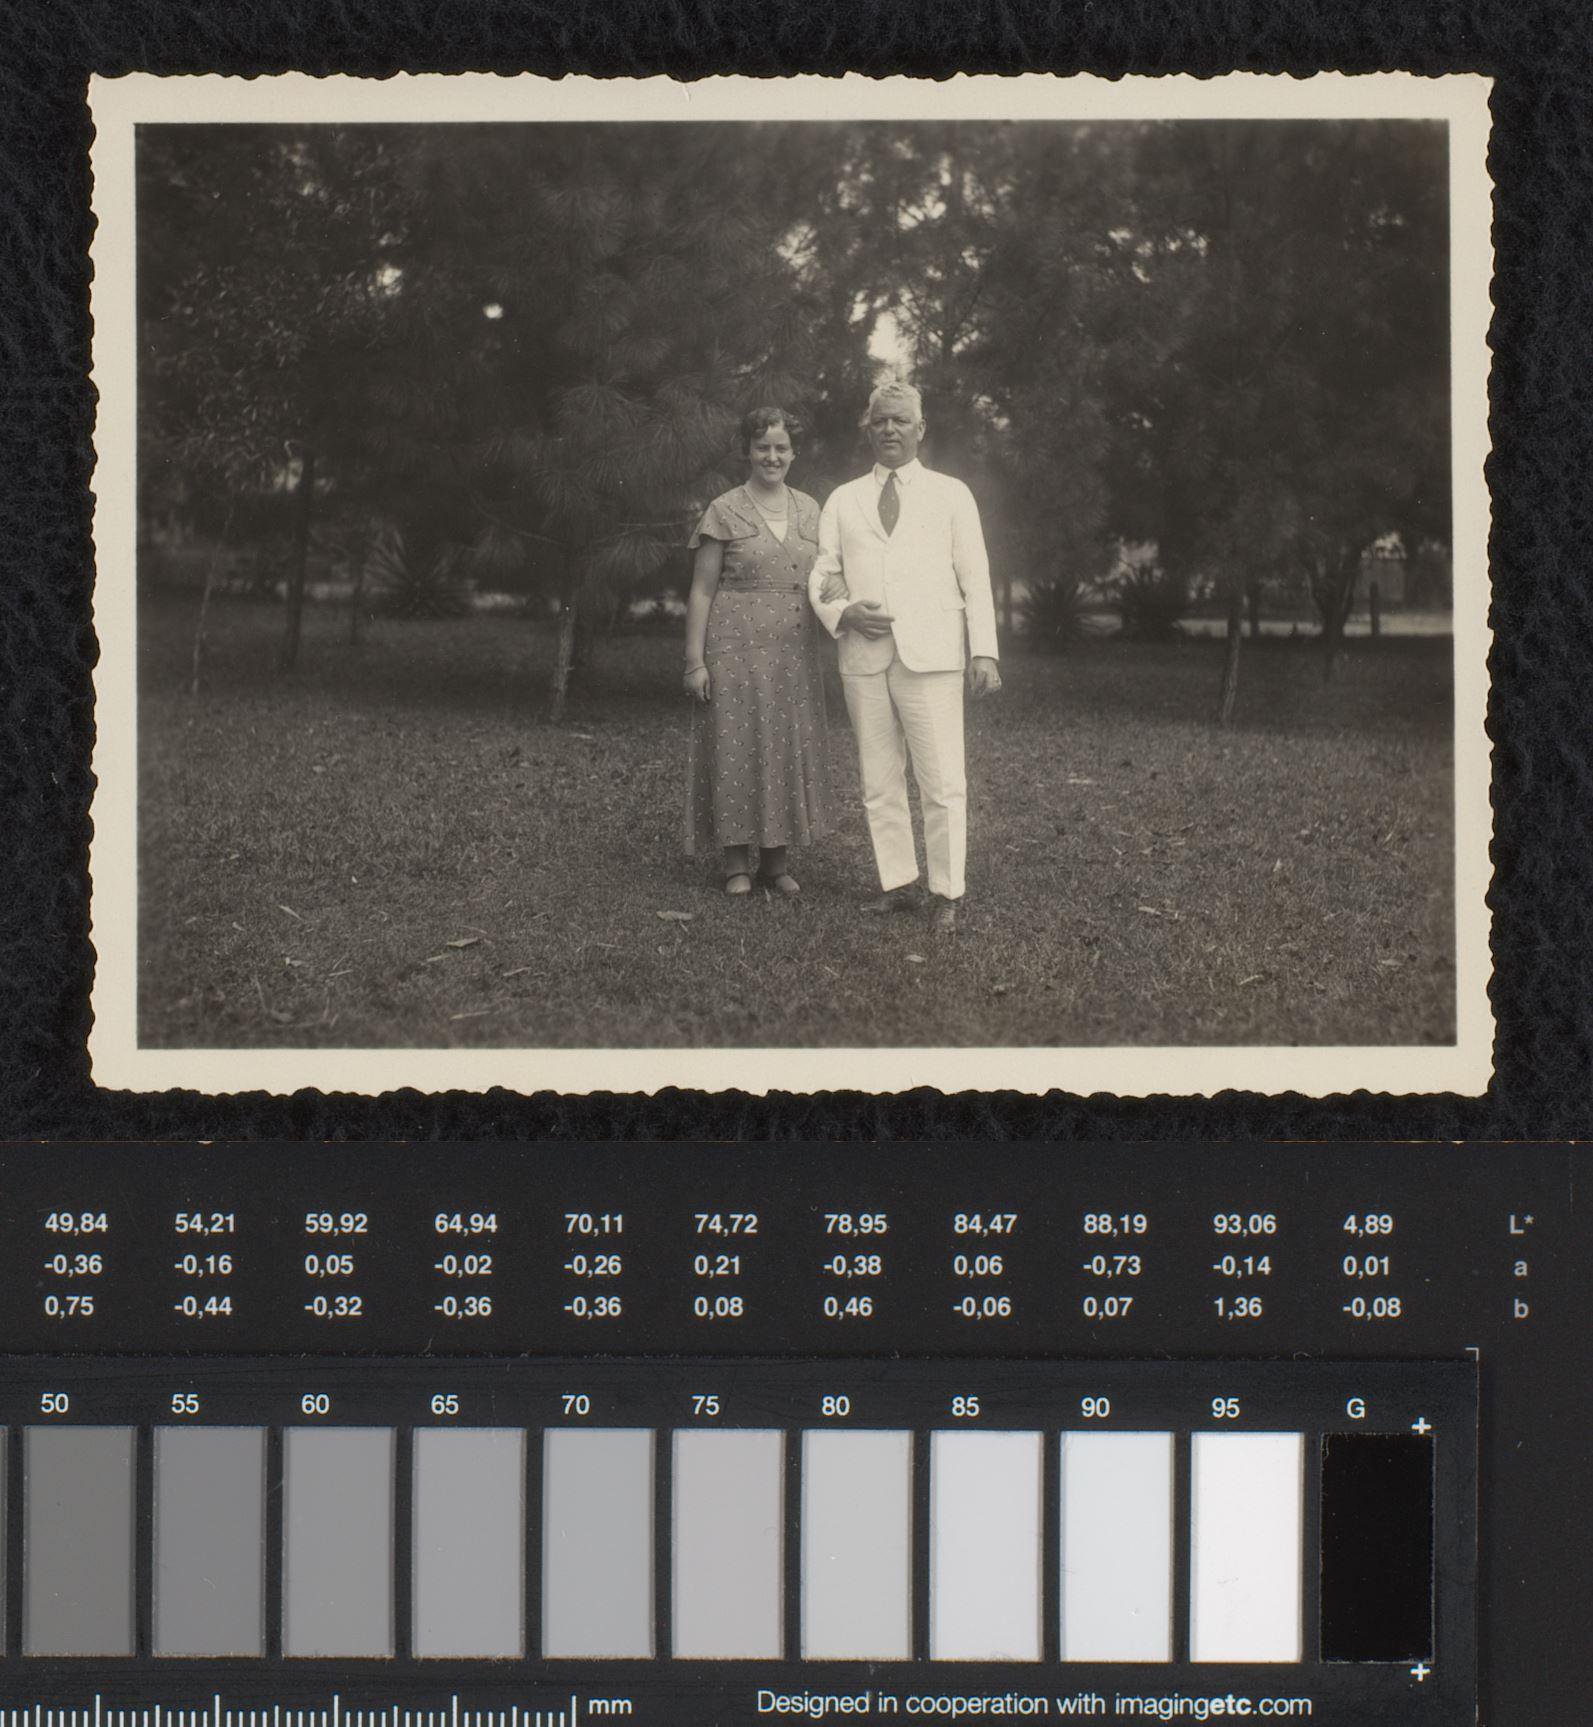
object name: photograph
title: Machteld Honig met echtgenoot, 1933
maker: Anonymous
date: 1908-1933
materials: photographic support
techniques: gelatin silver print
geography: sumatra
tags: rotterdam, official, koog aan de zaan, arnhem, machteld anna cornelia honig, historical persons - bb - woman, historical persons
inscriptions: inscription: ‘Taroetoeng Aug: '33’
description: Machteld Honig poserend met haar man in de tuin van hun woning in Taroetoeng, augustus 1933. Losse foto behorend bij het fotoalbum van Machteld Anna Cornelia Honig met foto's van Sumatra in de periode 1929-1933.